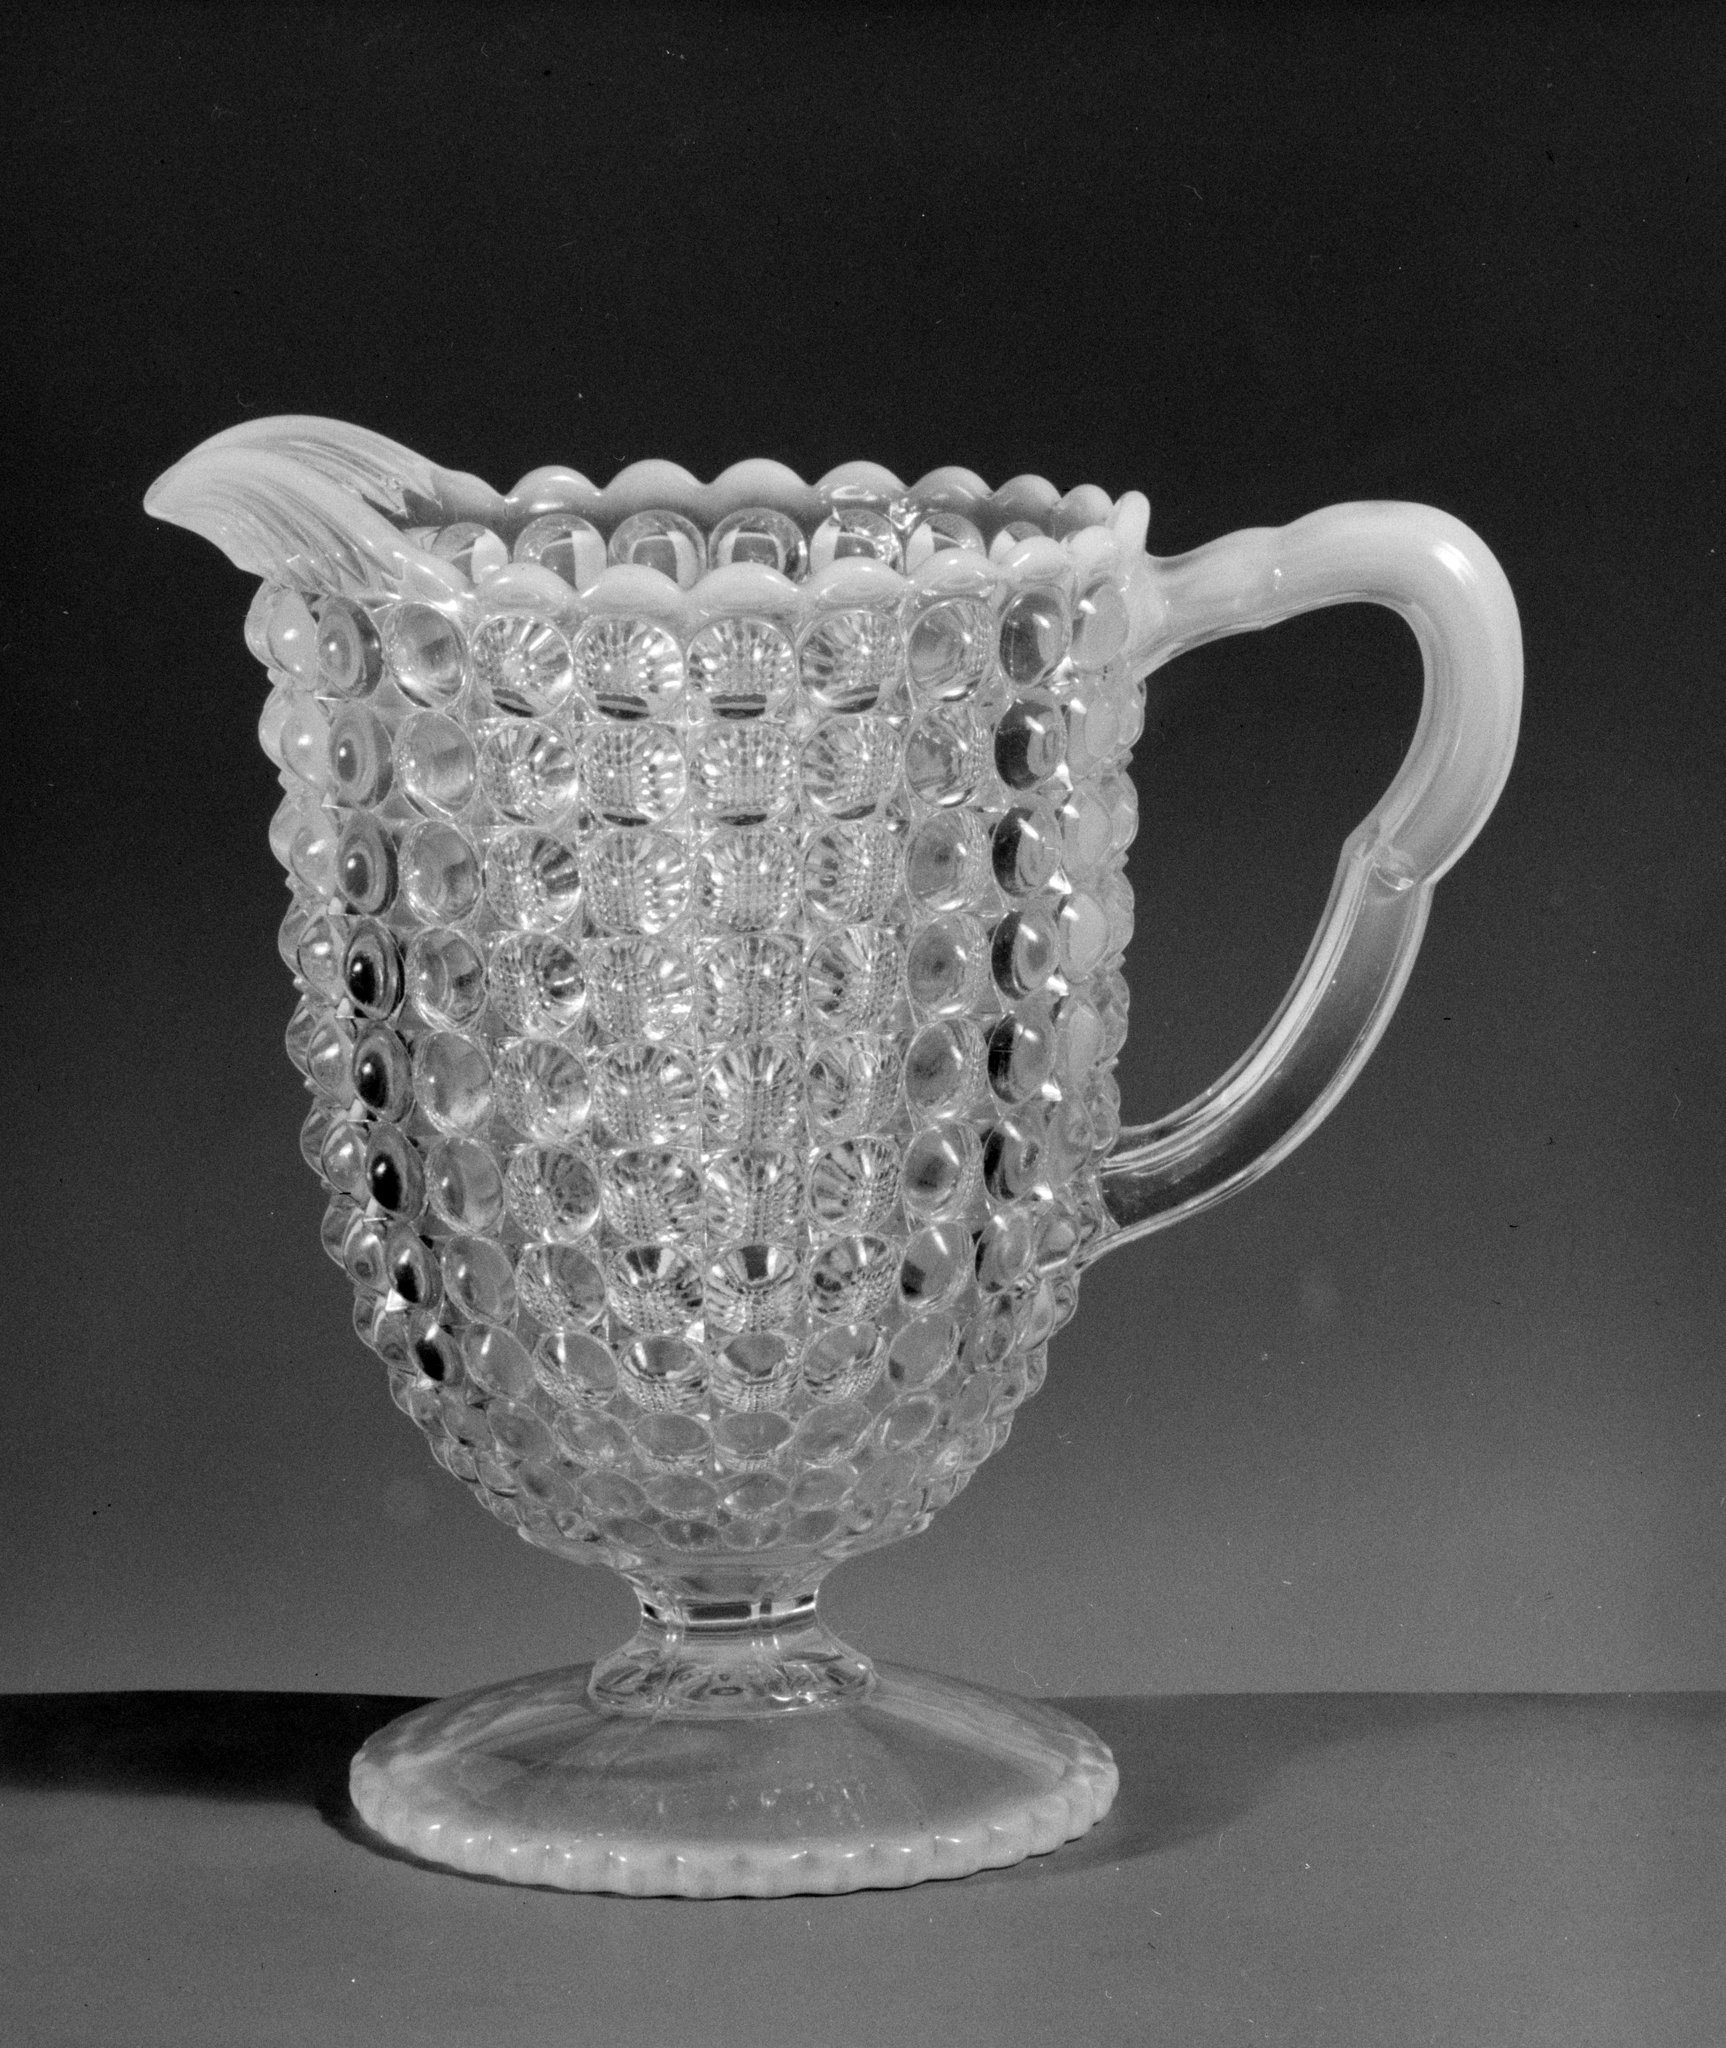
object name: milk pitcher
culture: american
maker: richards and hartley flint glass co.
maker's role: maker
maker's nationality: american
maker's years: 1867-1890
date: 1870-1880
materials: glass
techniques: pressed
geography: united states